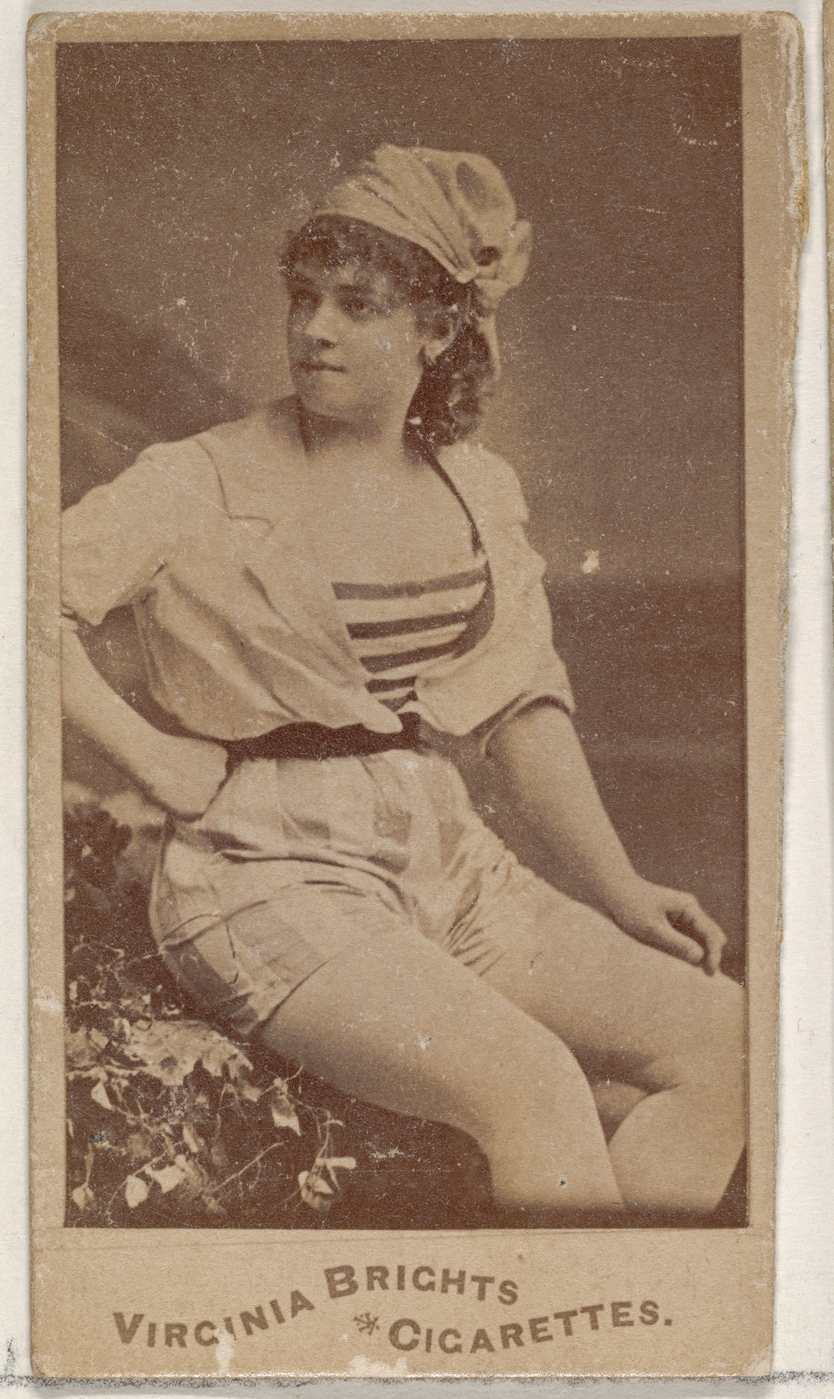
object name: photograph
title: From the Actors and Actresses series (N45, Type 4) for Virginia Brights Cigarettes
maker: allen & ginter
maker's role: publisher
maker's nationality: american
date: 1888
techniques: albumen silver print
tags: portraits,women,actresses